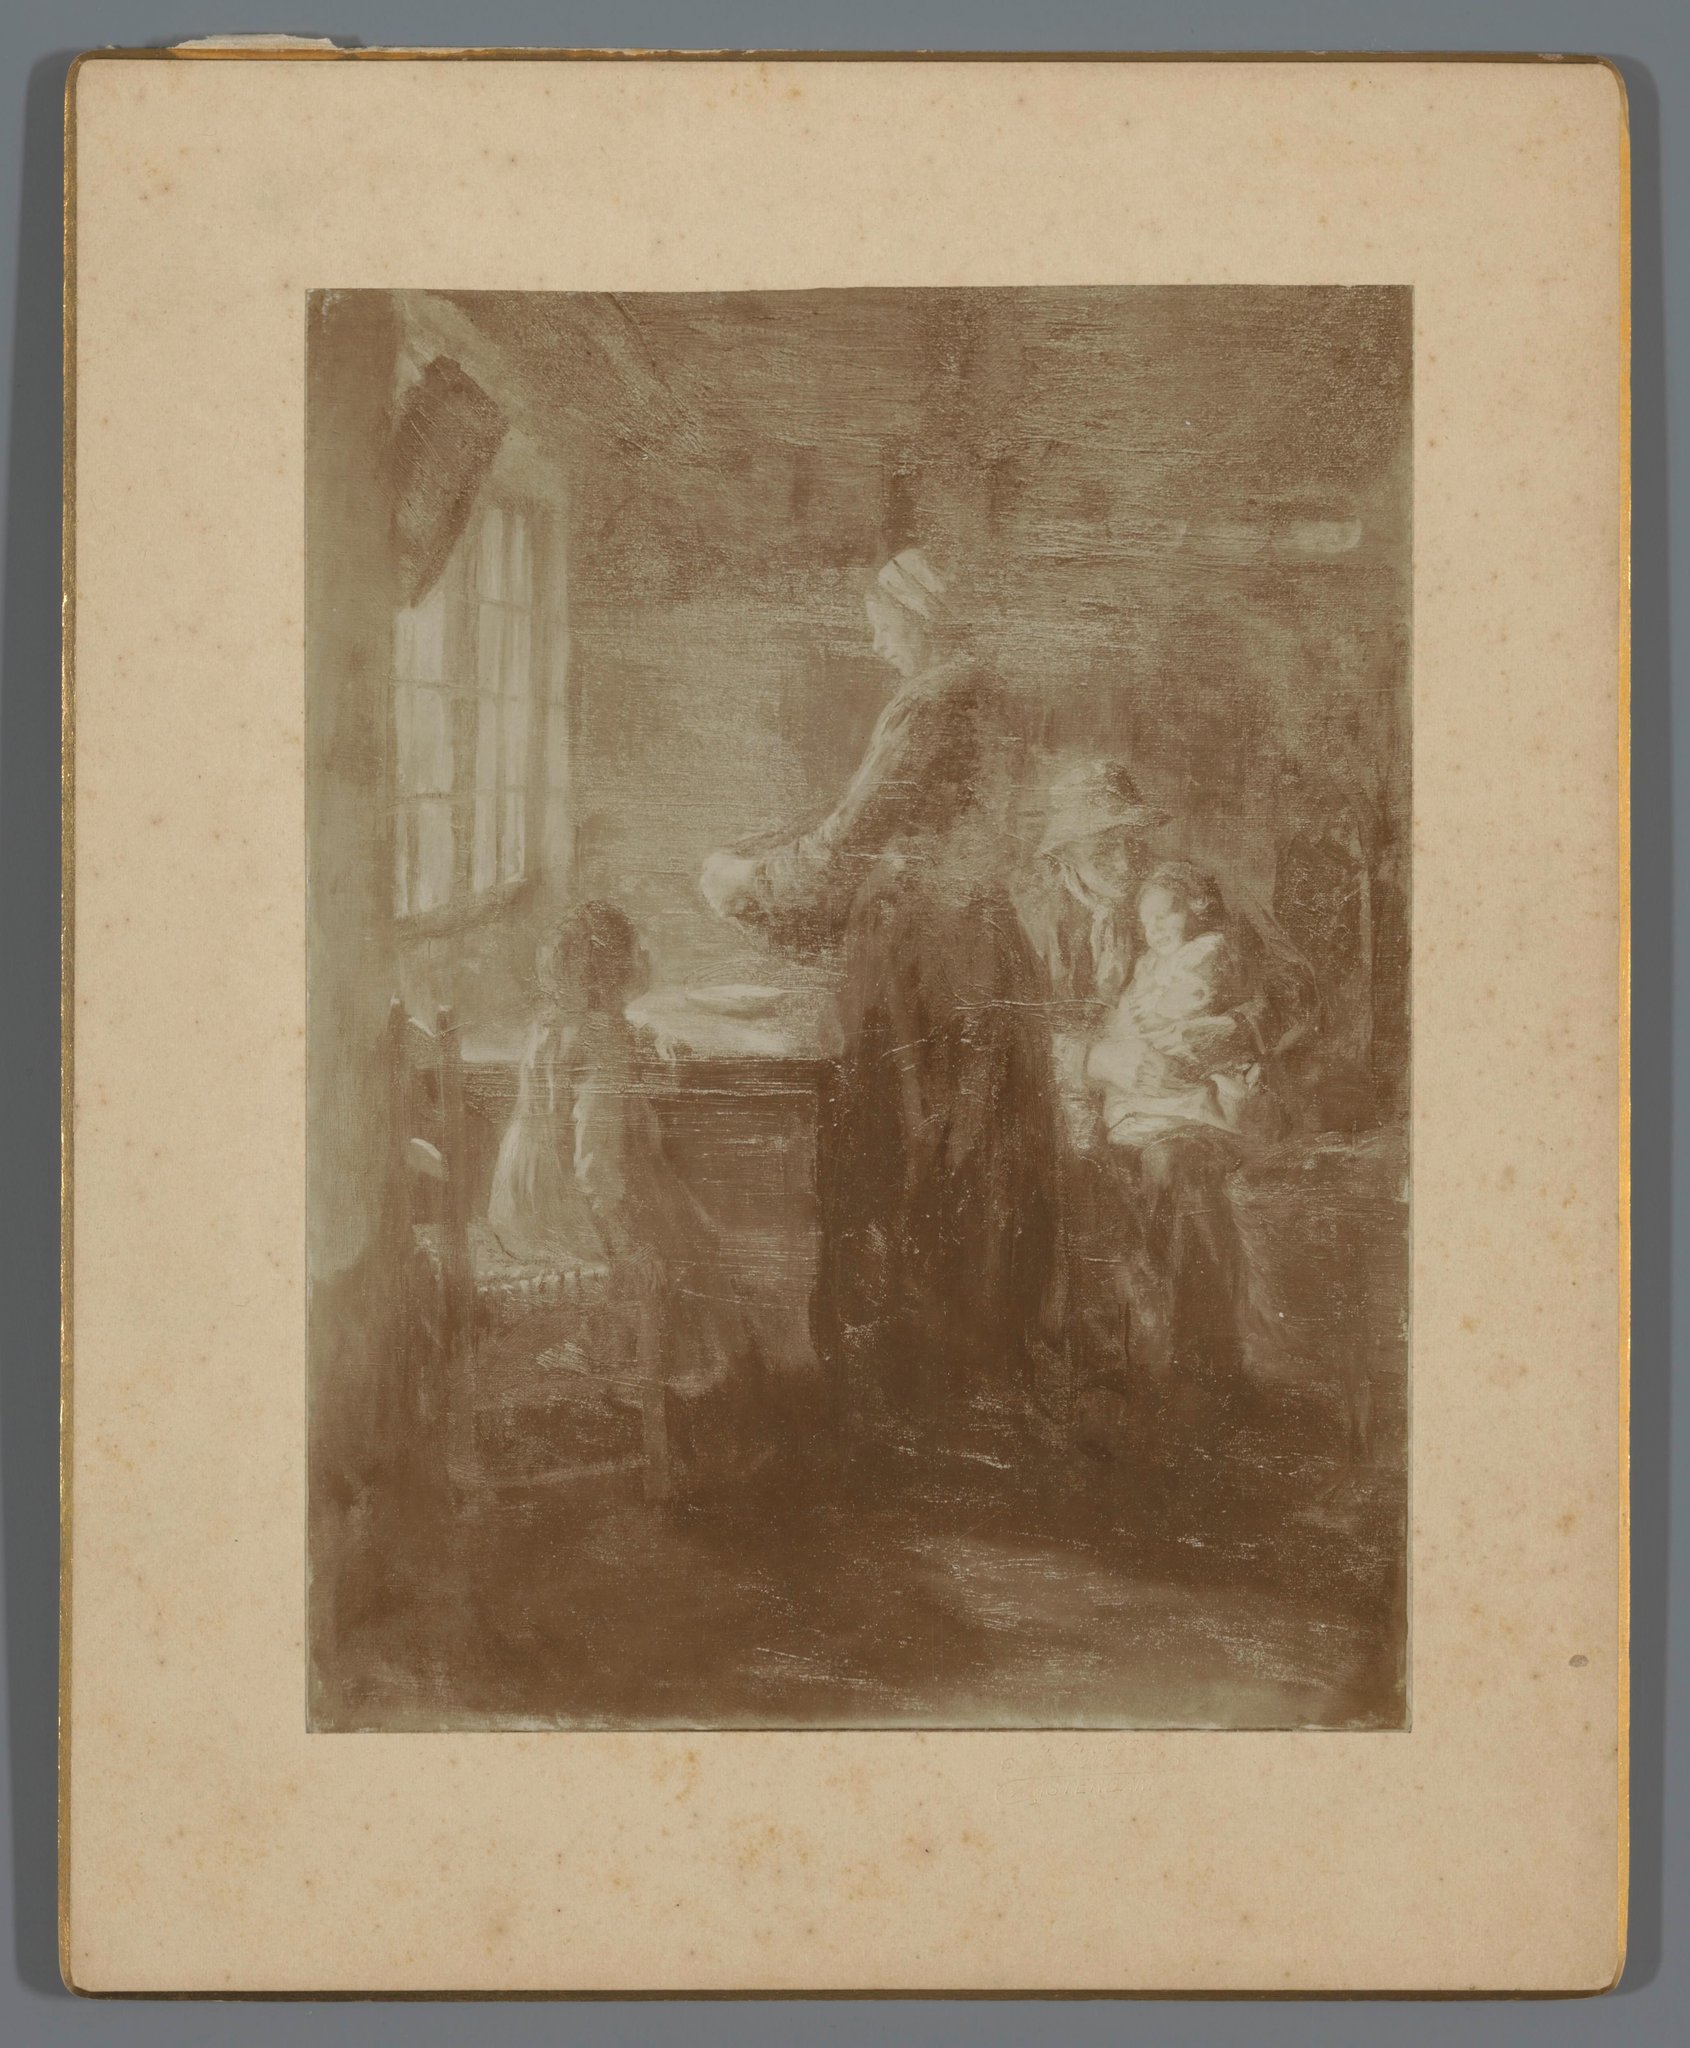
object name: photograph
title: Fotoreproductie van schilderij door Albert Neuhuys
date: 1850-1900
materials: cardboard, photographic support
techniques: gelatin silver print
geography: amsterdam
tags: interior of the house, children (first degree family relationships), parents (first degree family relationships)